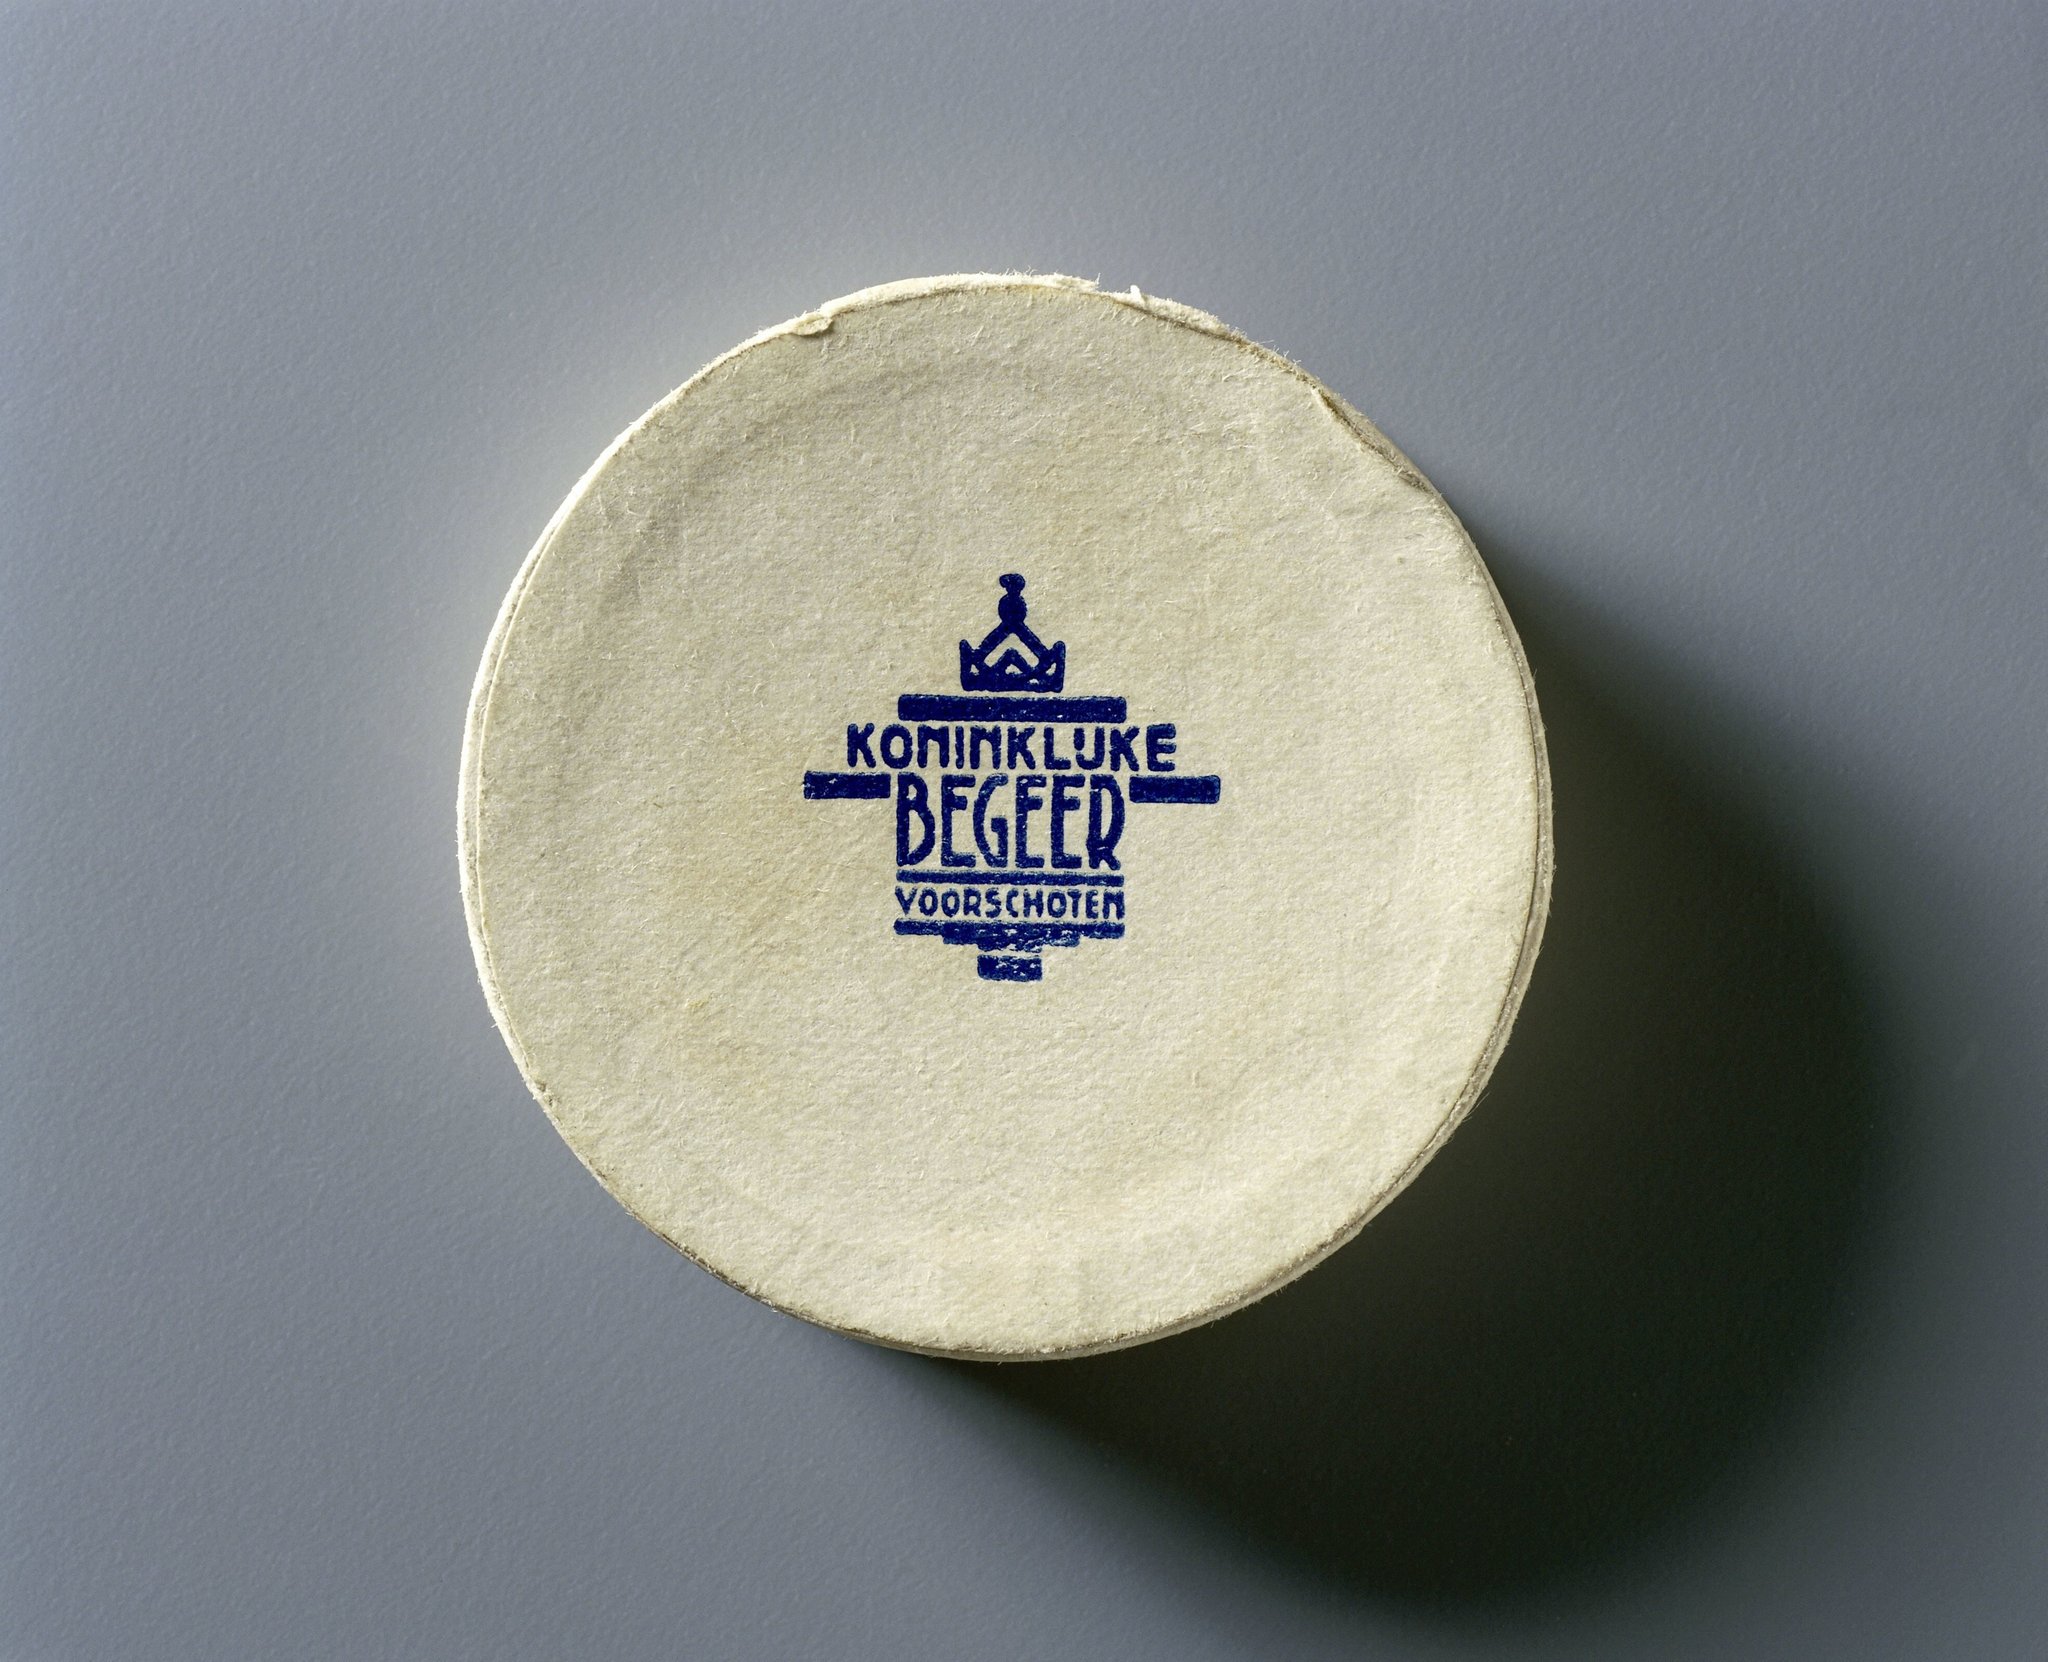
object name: box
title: Doosje bij penning 100-jarig bestaan der Nederlandsche Maatschappij tot bevordering der pharmacie 1842 - 1942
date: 1942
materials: cardboard, paper, velvet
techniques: printing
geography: voorschoten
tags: koninklijke nederlandse maatschappij ter bevordering der pharmacie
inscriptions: inscription: ‘KONINKLIJKE BEGEER VOORSCHOTEN’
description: Wit rond kartonnen doosje, binnenzijde met grijs fluweel bekleed. Deksel v.z.v. opdruk.